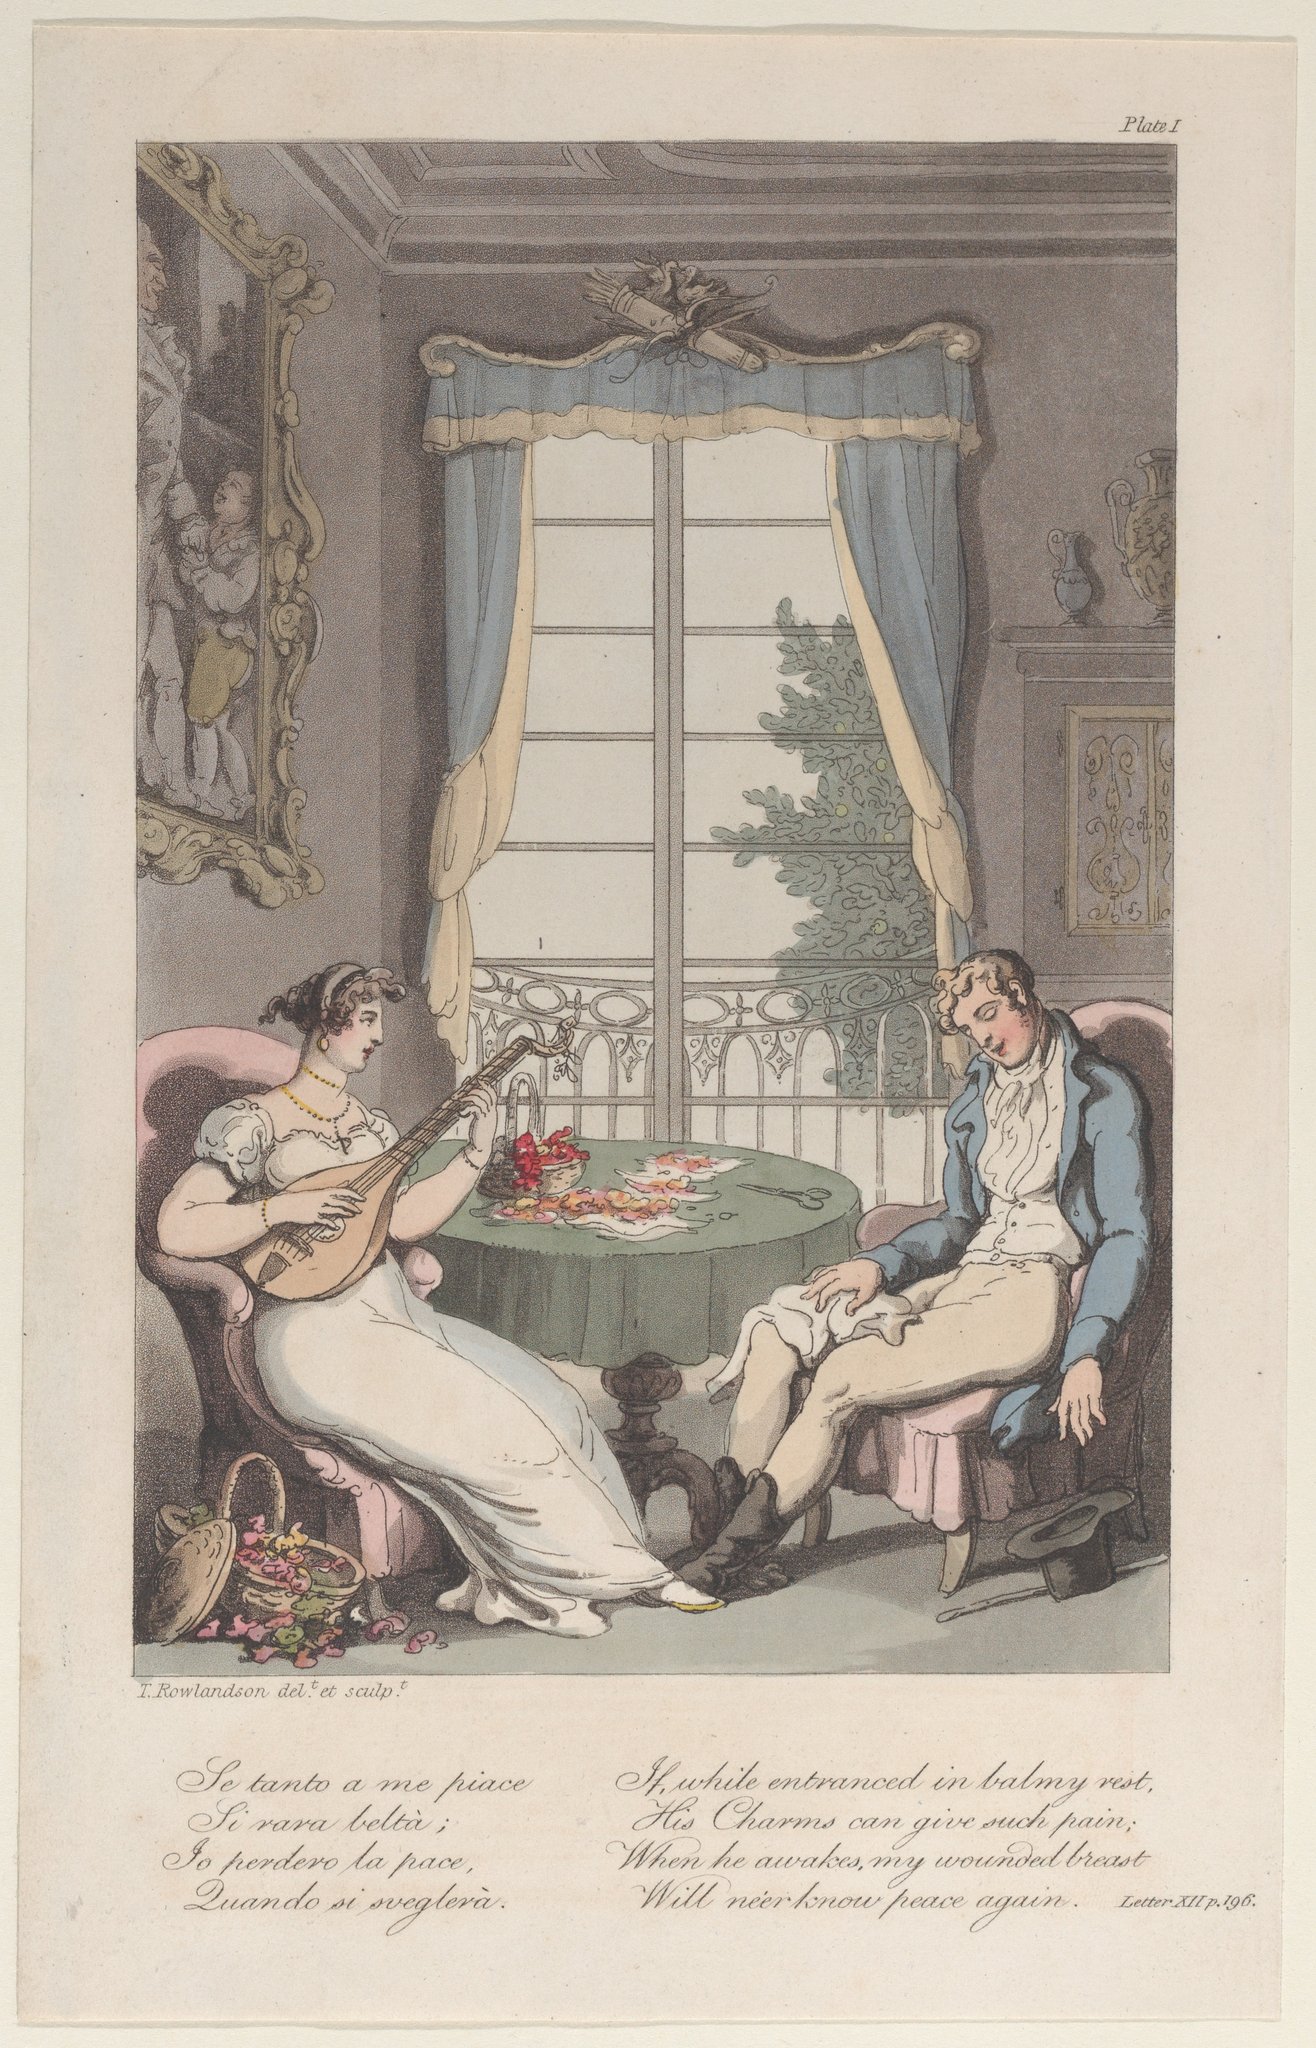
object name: print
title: Title page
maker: thomas rowlandson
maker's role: artist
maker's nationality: british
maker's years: 1757-1827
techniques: aquatint, engraving, etching, letterpress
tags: musical instruments,sleeping,men,women